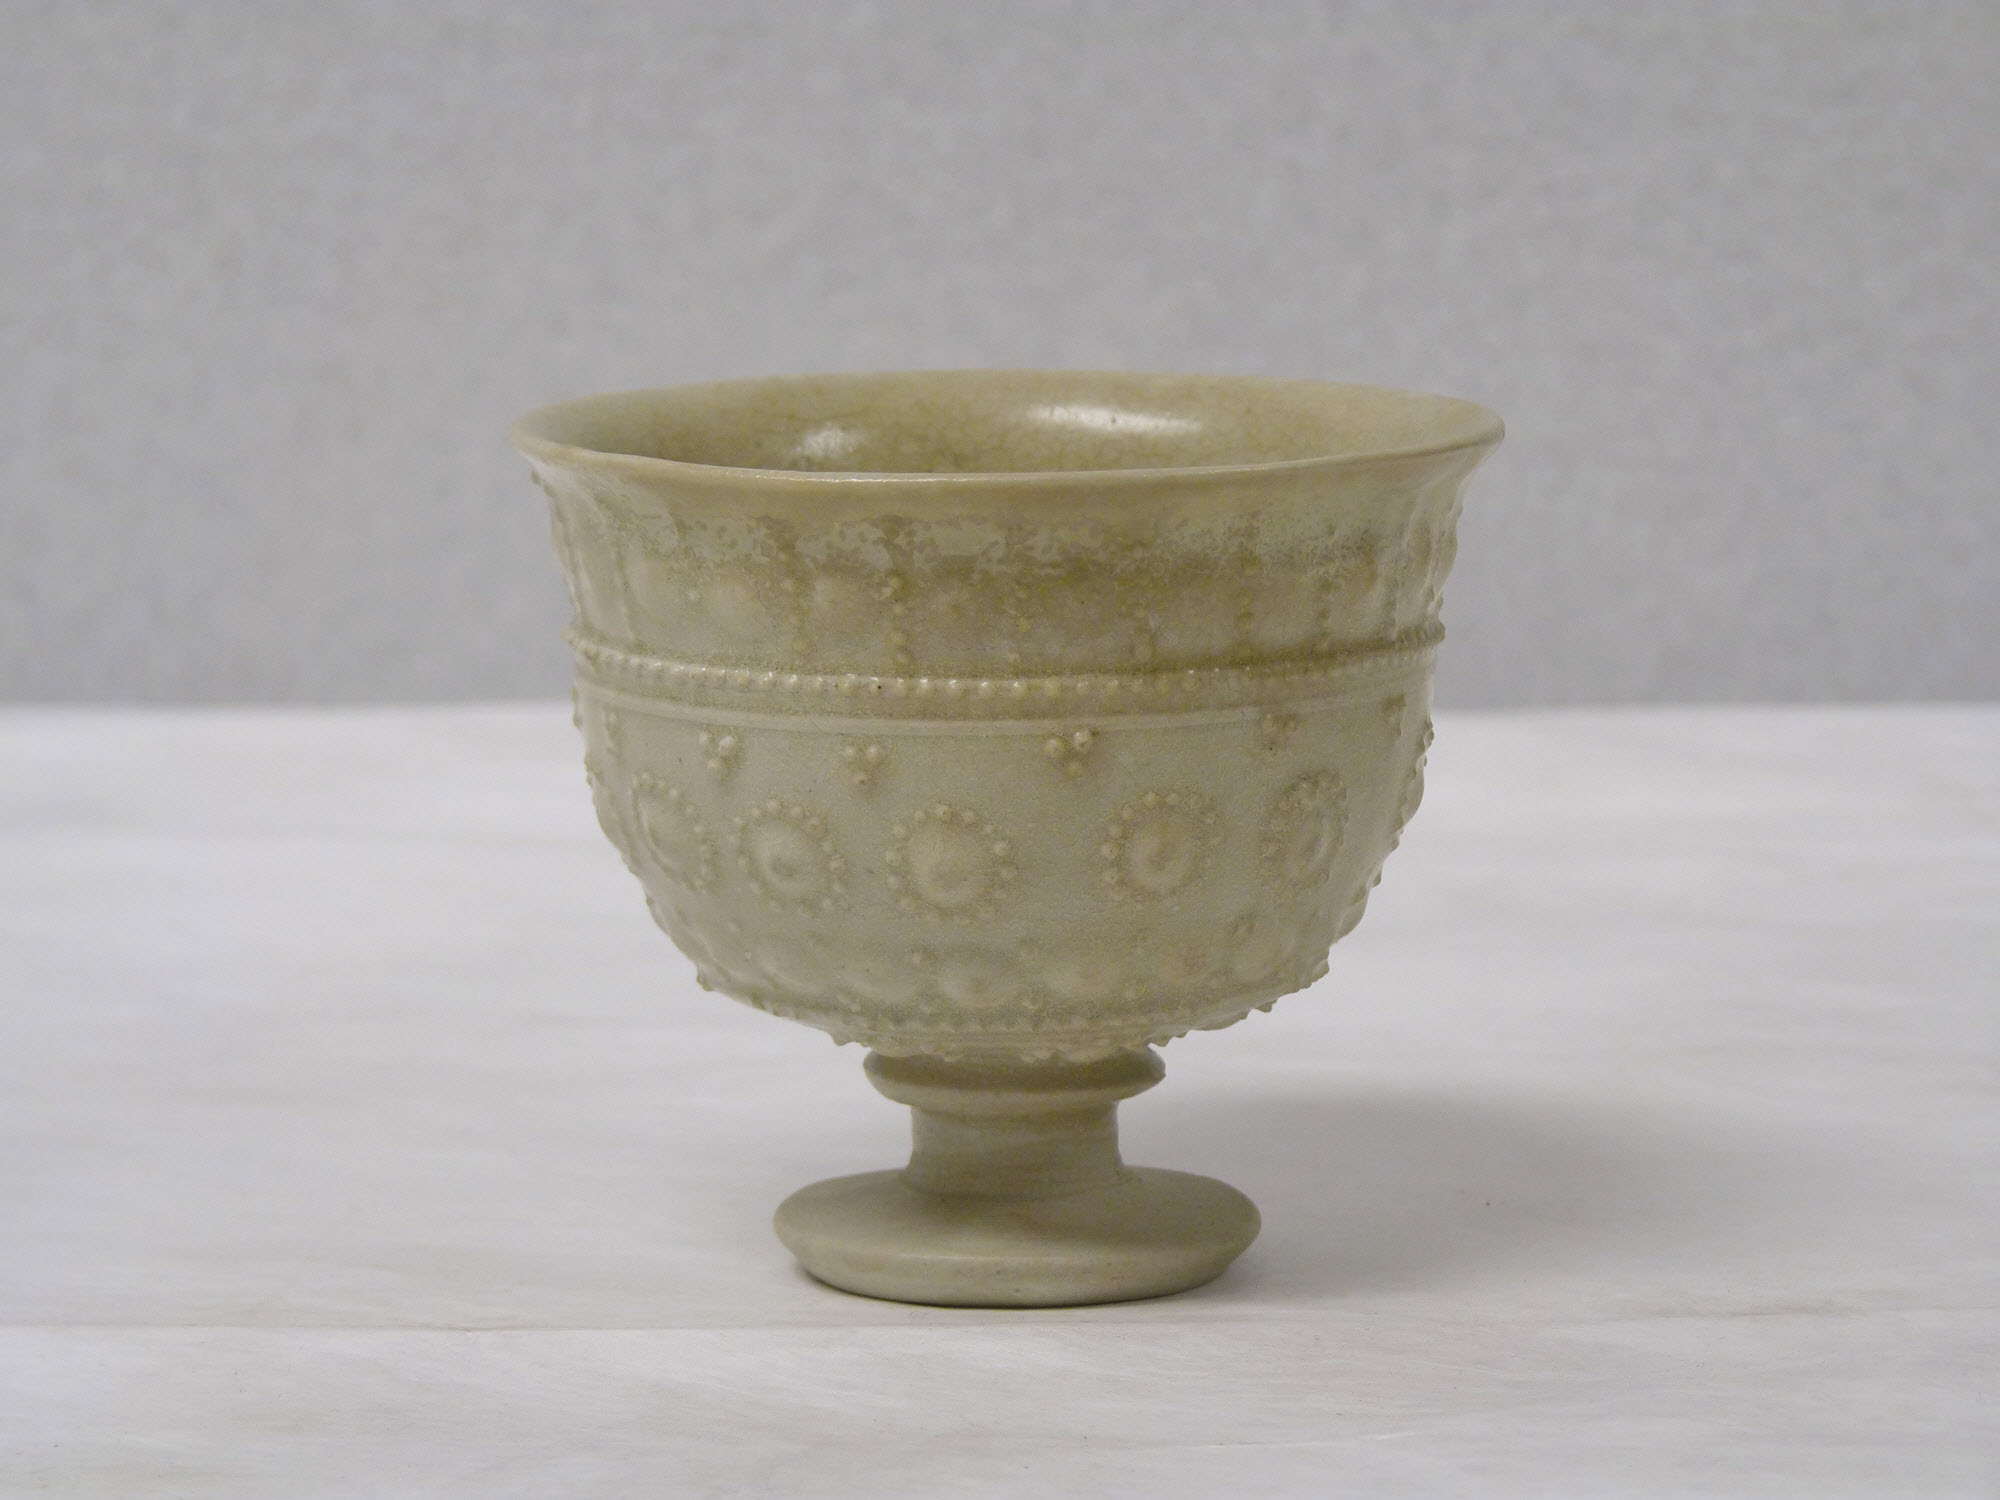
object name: stem cup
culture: chinese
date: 567-633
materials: stoneware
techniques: glazing